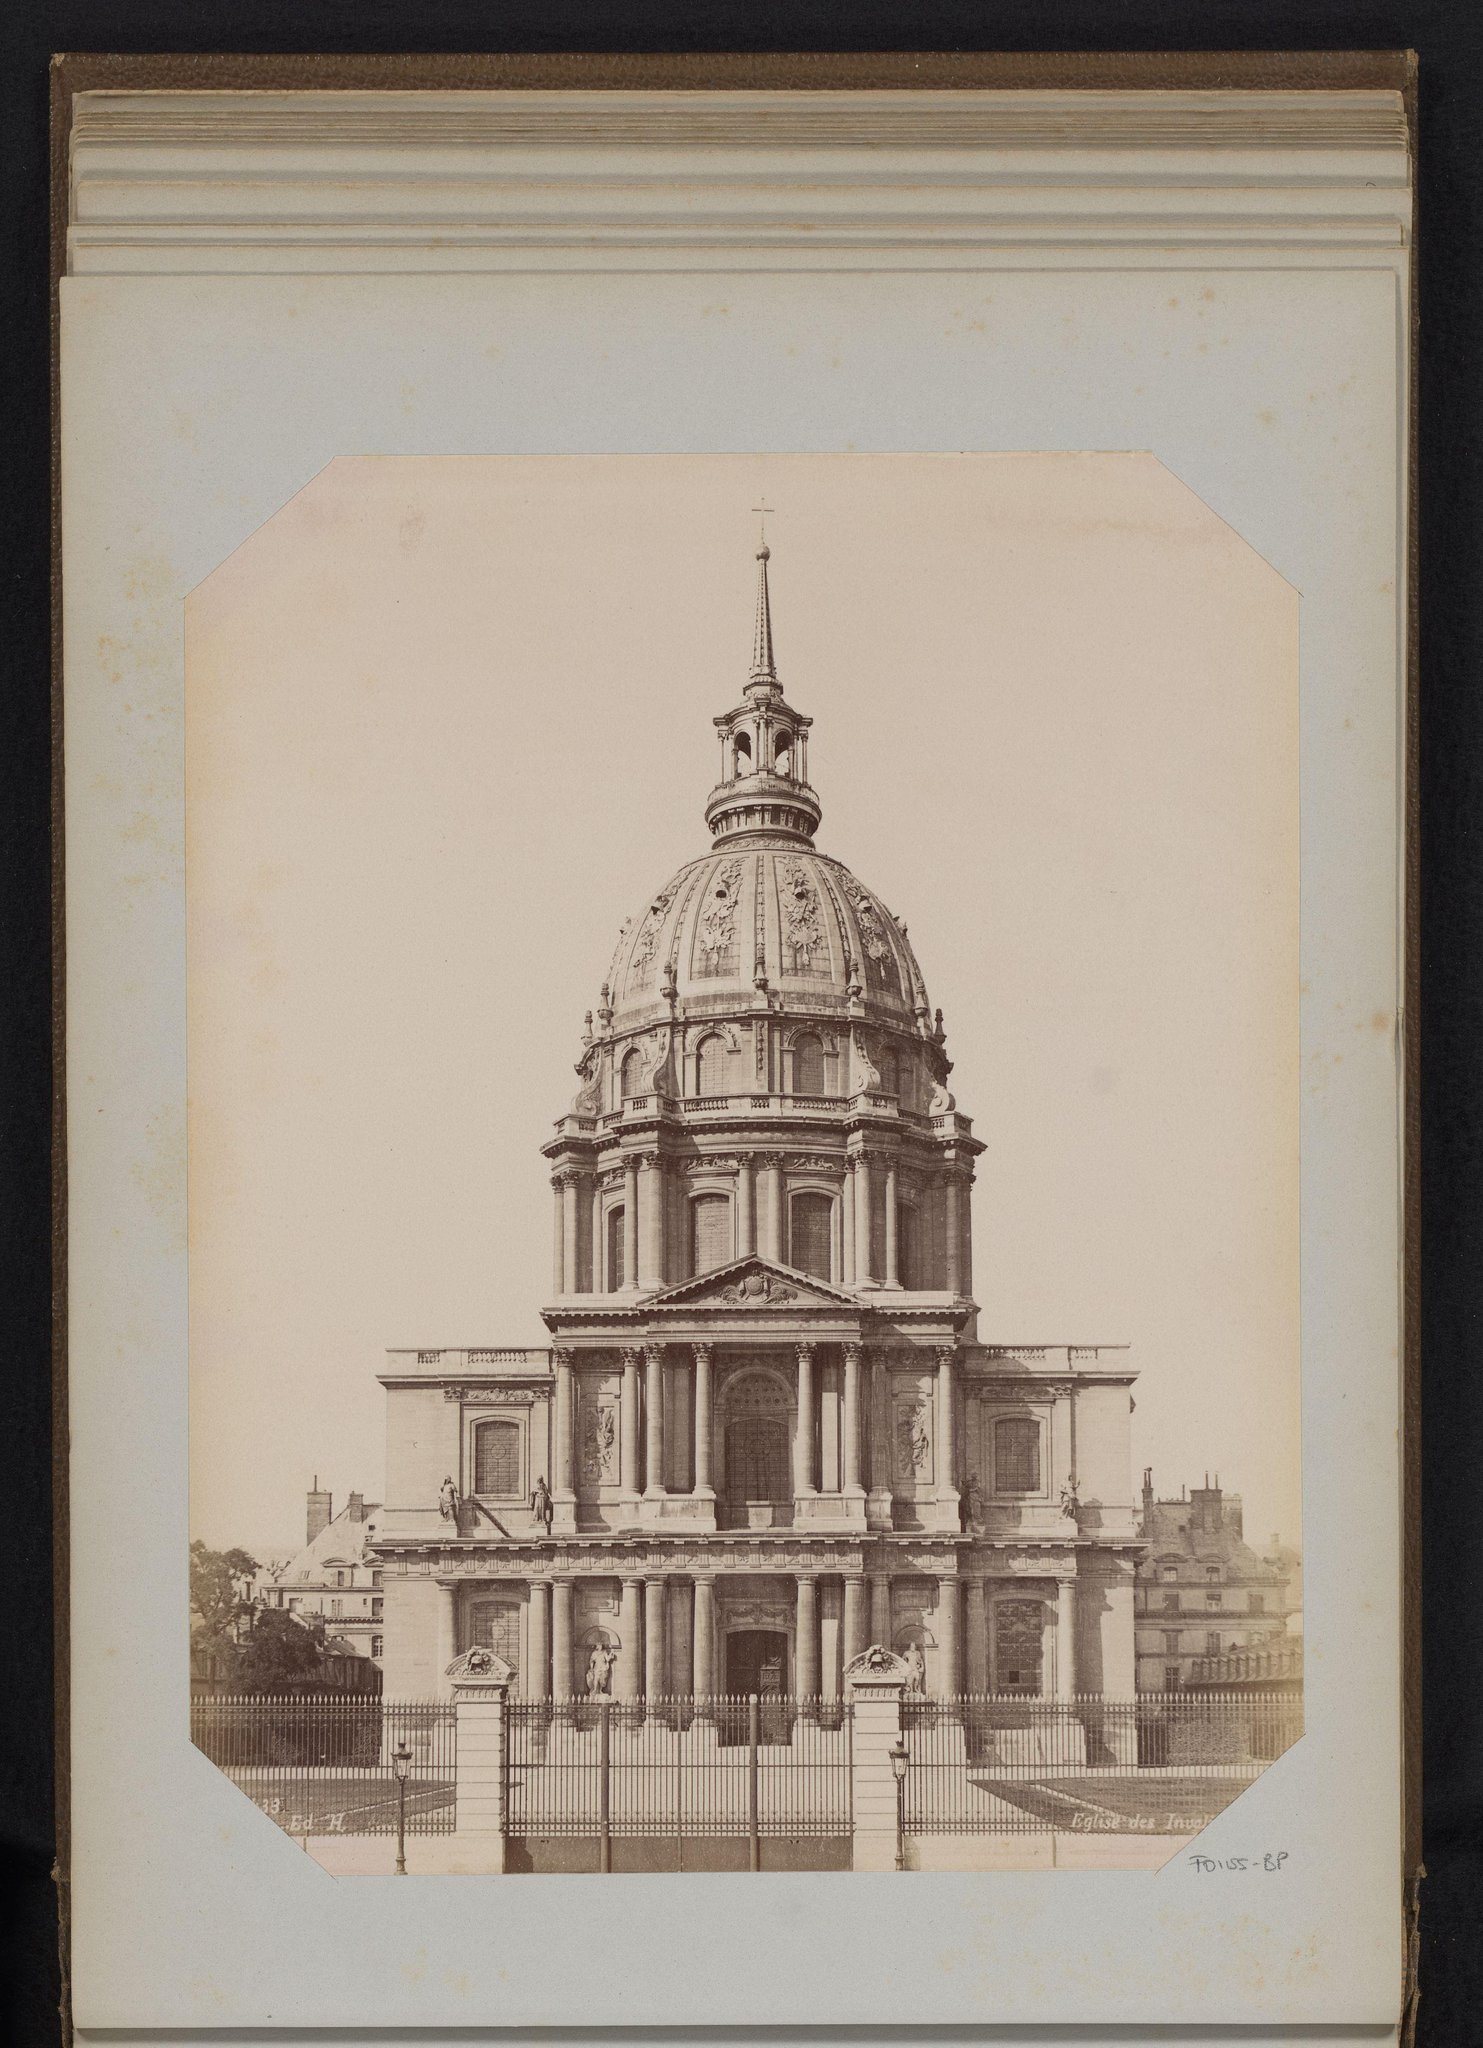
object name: photograph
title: Gezicht op de Cathédrale de Saint-Louis-des-Invalides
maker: edouard hautecoer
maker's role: publisher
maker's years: 1847-1904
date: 1890-1898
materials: photographic support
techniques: albumen print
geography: paris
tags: church (exterior)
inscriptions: inscription: ‘433/ Paris. Ed. H./ Eglise des Invalides’, retailer's mark: ‘E. Hautecoeur/ Estampes Photographies/ 35 Avenue de l'Opéra, 35/ Paris’